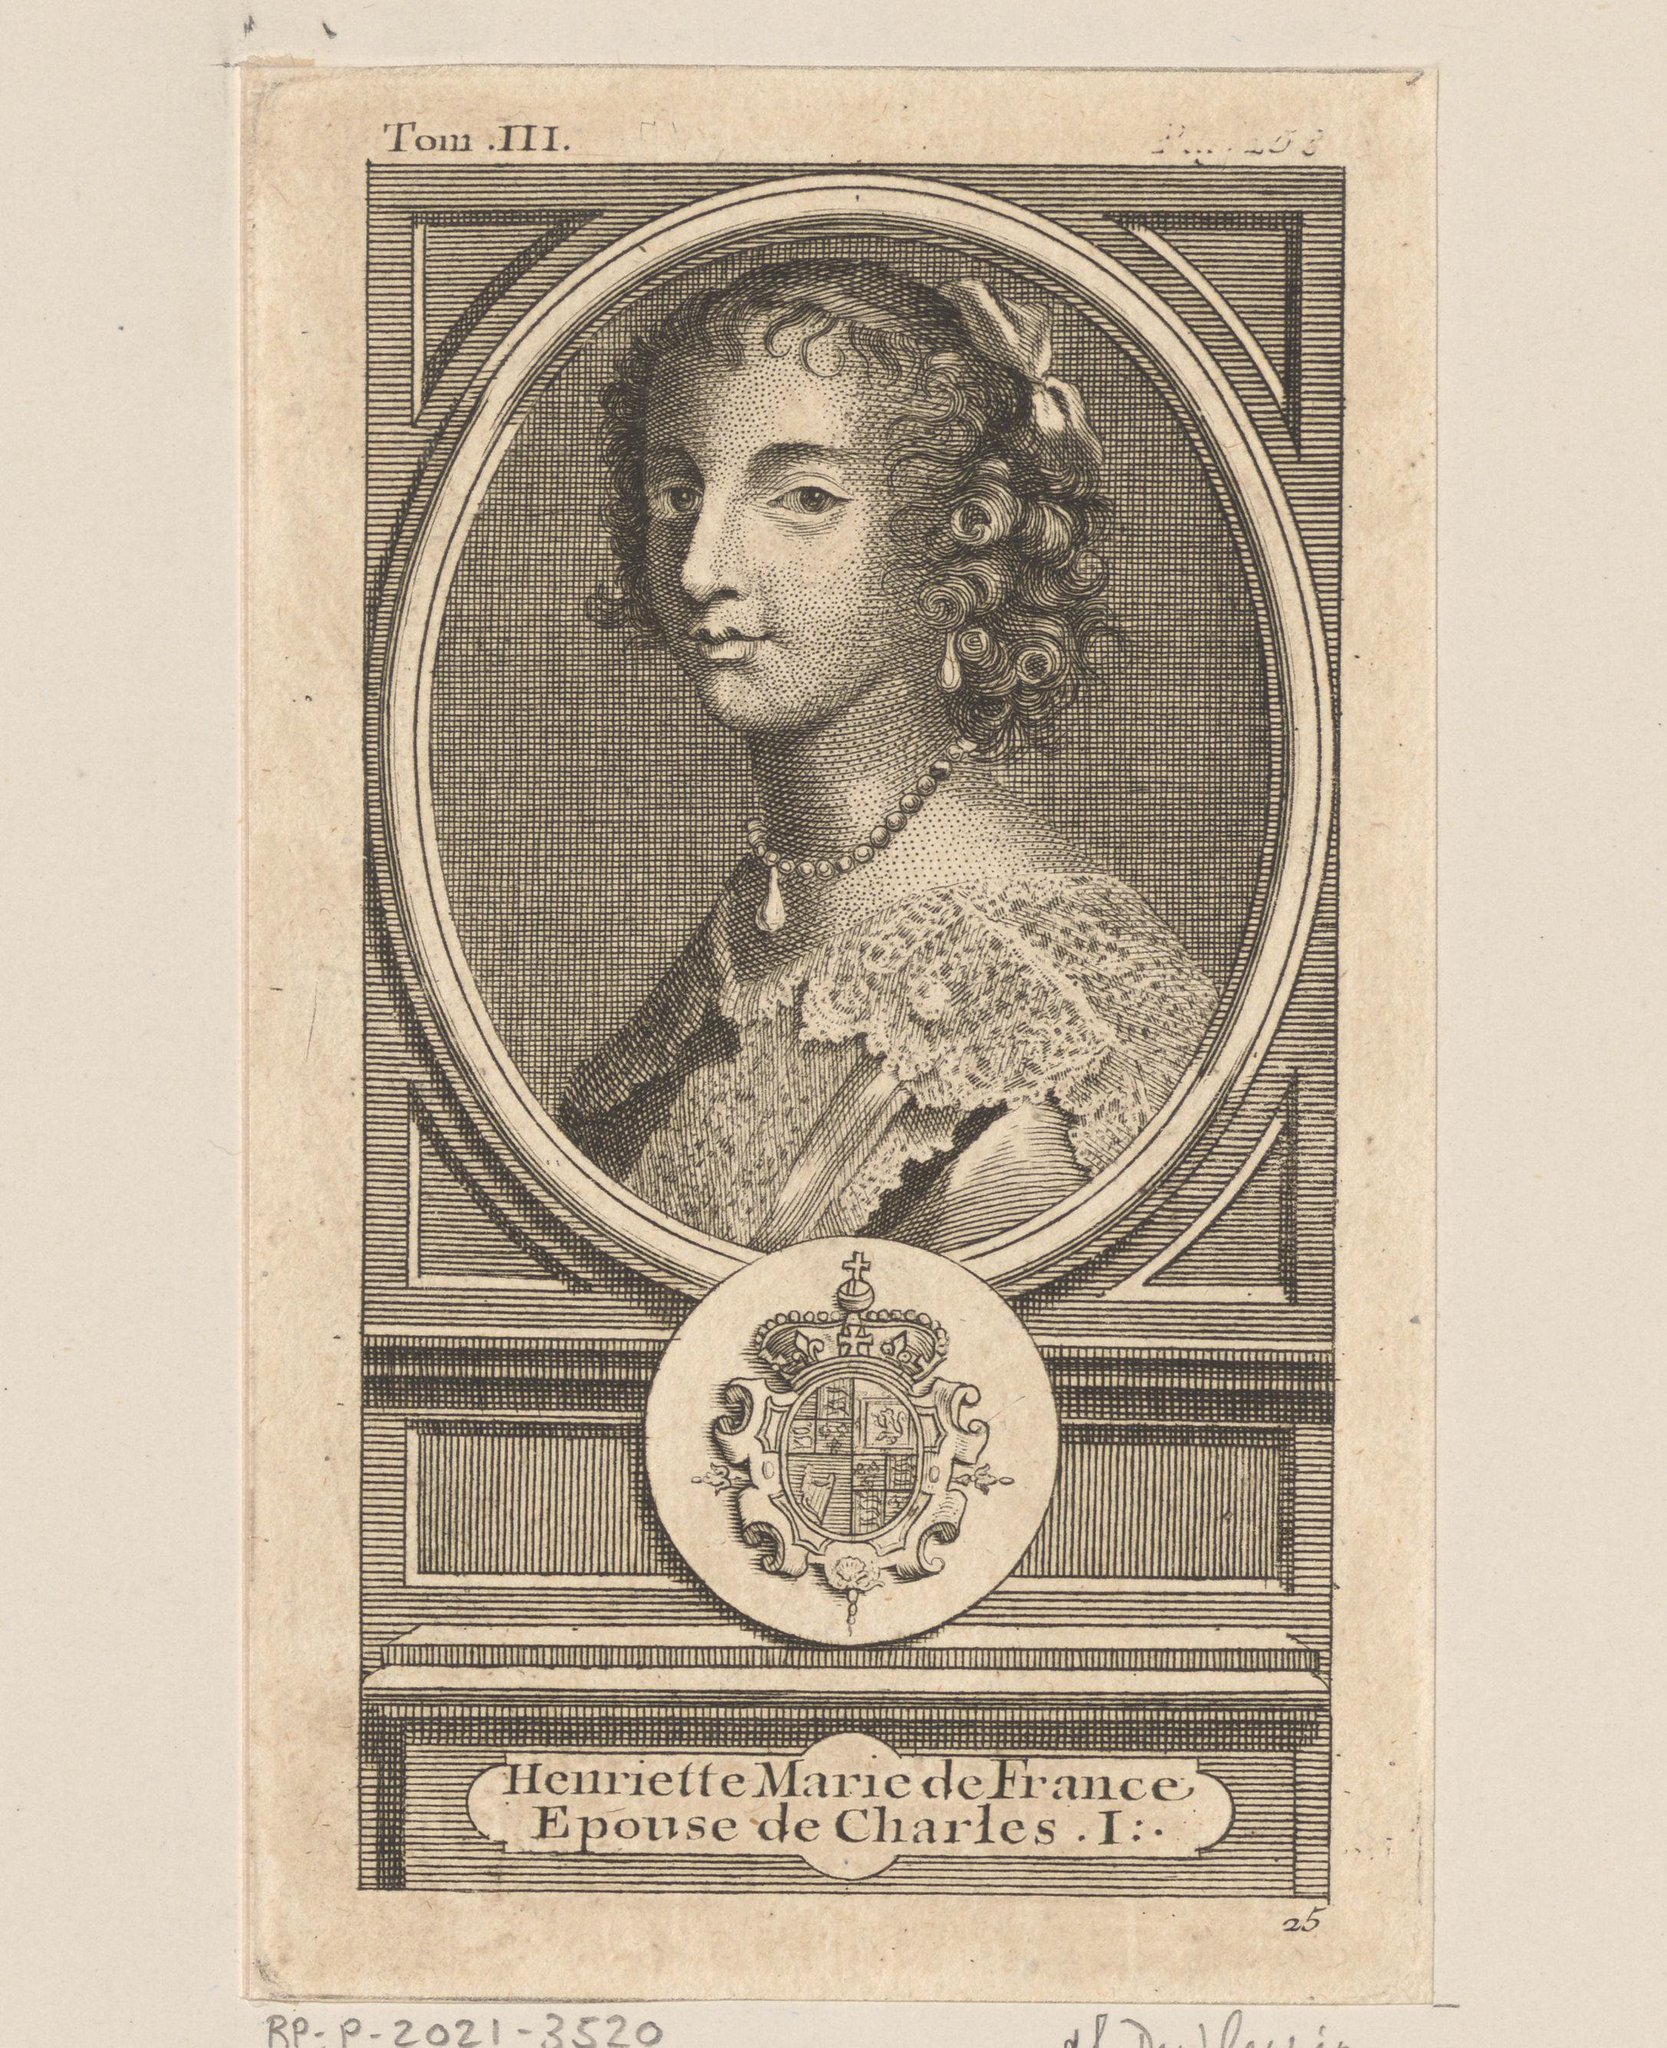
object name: book illustration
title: Portret van Henriëtta Maria van Frankrijk, koningin van Engeland, Schotland en Ierland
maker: Anonymous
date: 1750-1762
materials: paper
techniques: engraving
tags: henriëtta maria van frankrijk (koningin van engeland, schotland en ierland), historical persons - bb - woman, queen, armorial bearing, heraldry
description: Prent gebruikt in: Orleans, Pierre Joseph d’. Histoire des revolutions d'Angleterre, depuis le commencement de la monarchie. Parijs: Pierre-François Giffart en Jacques Rolin, 1750. Prent ook gebruikt in de 1762-editie uitgegeven in Lyon door de gebroeders Duplain. Mogelijk ook gebruikt in andere edities of publicaties.